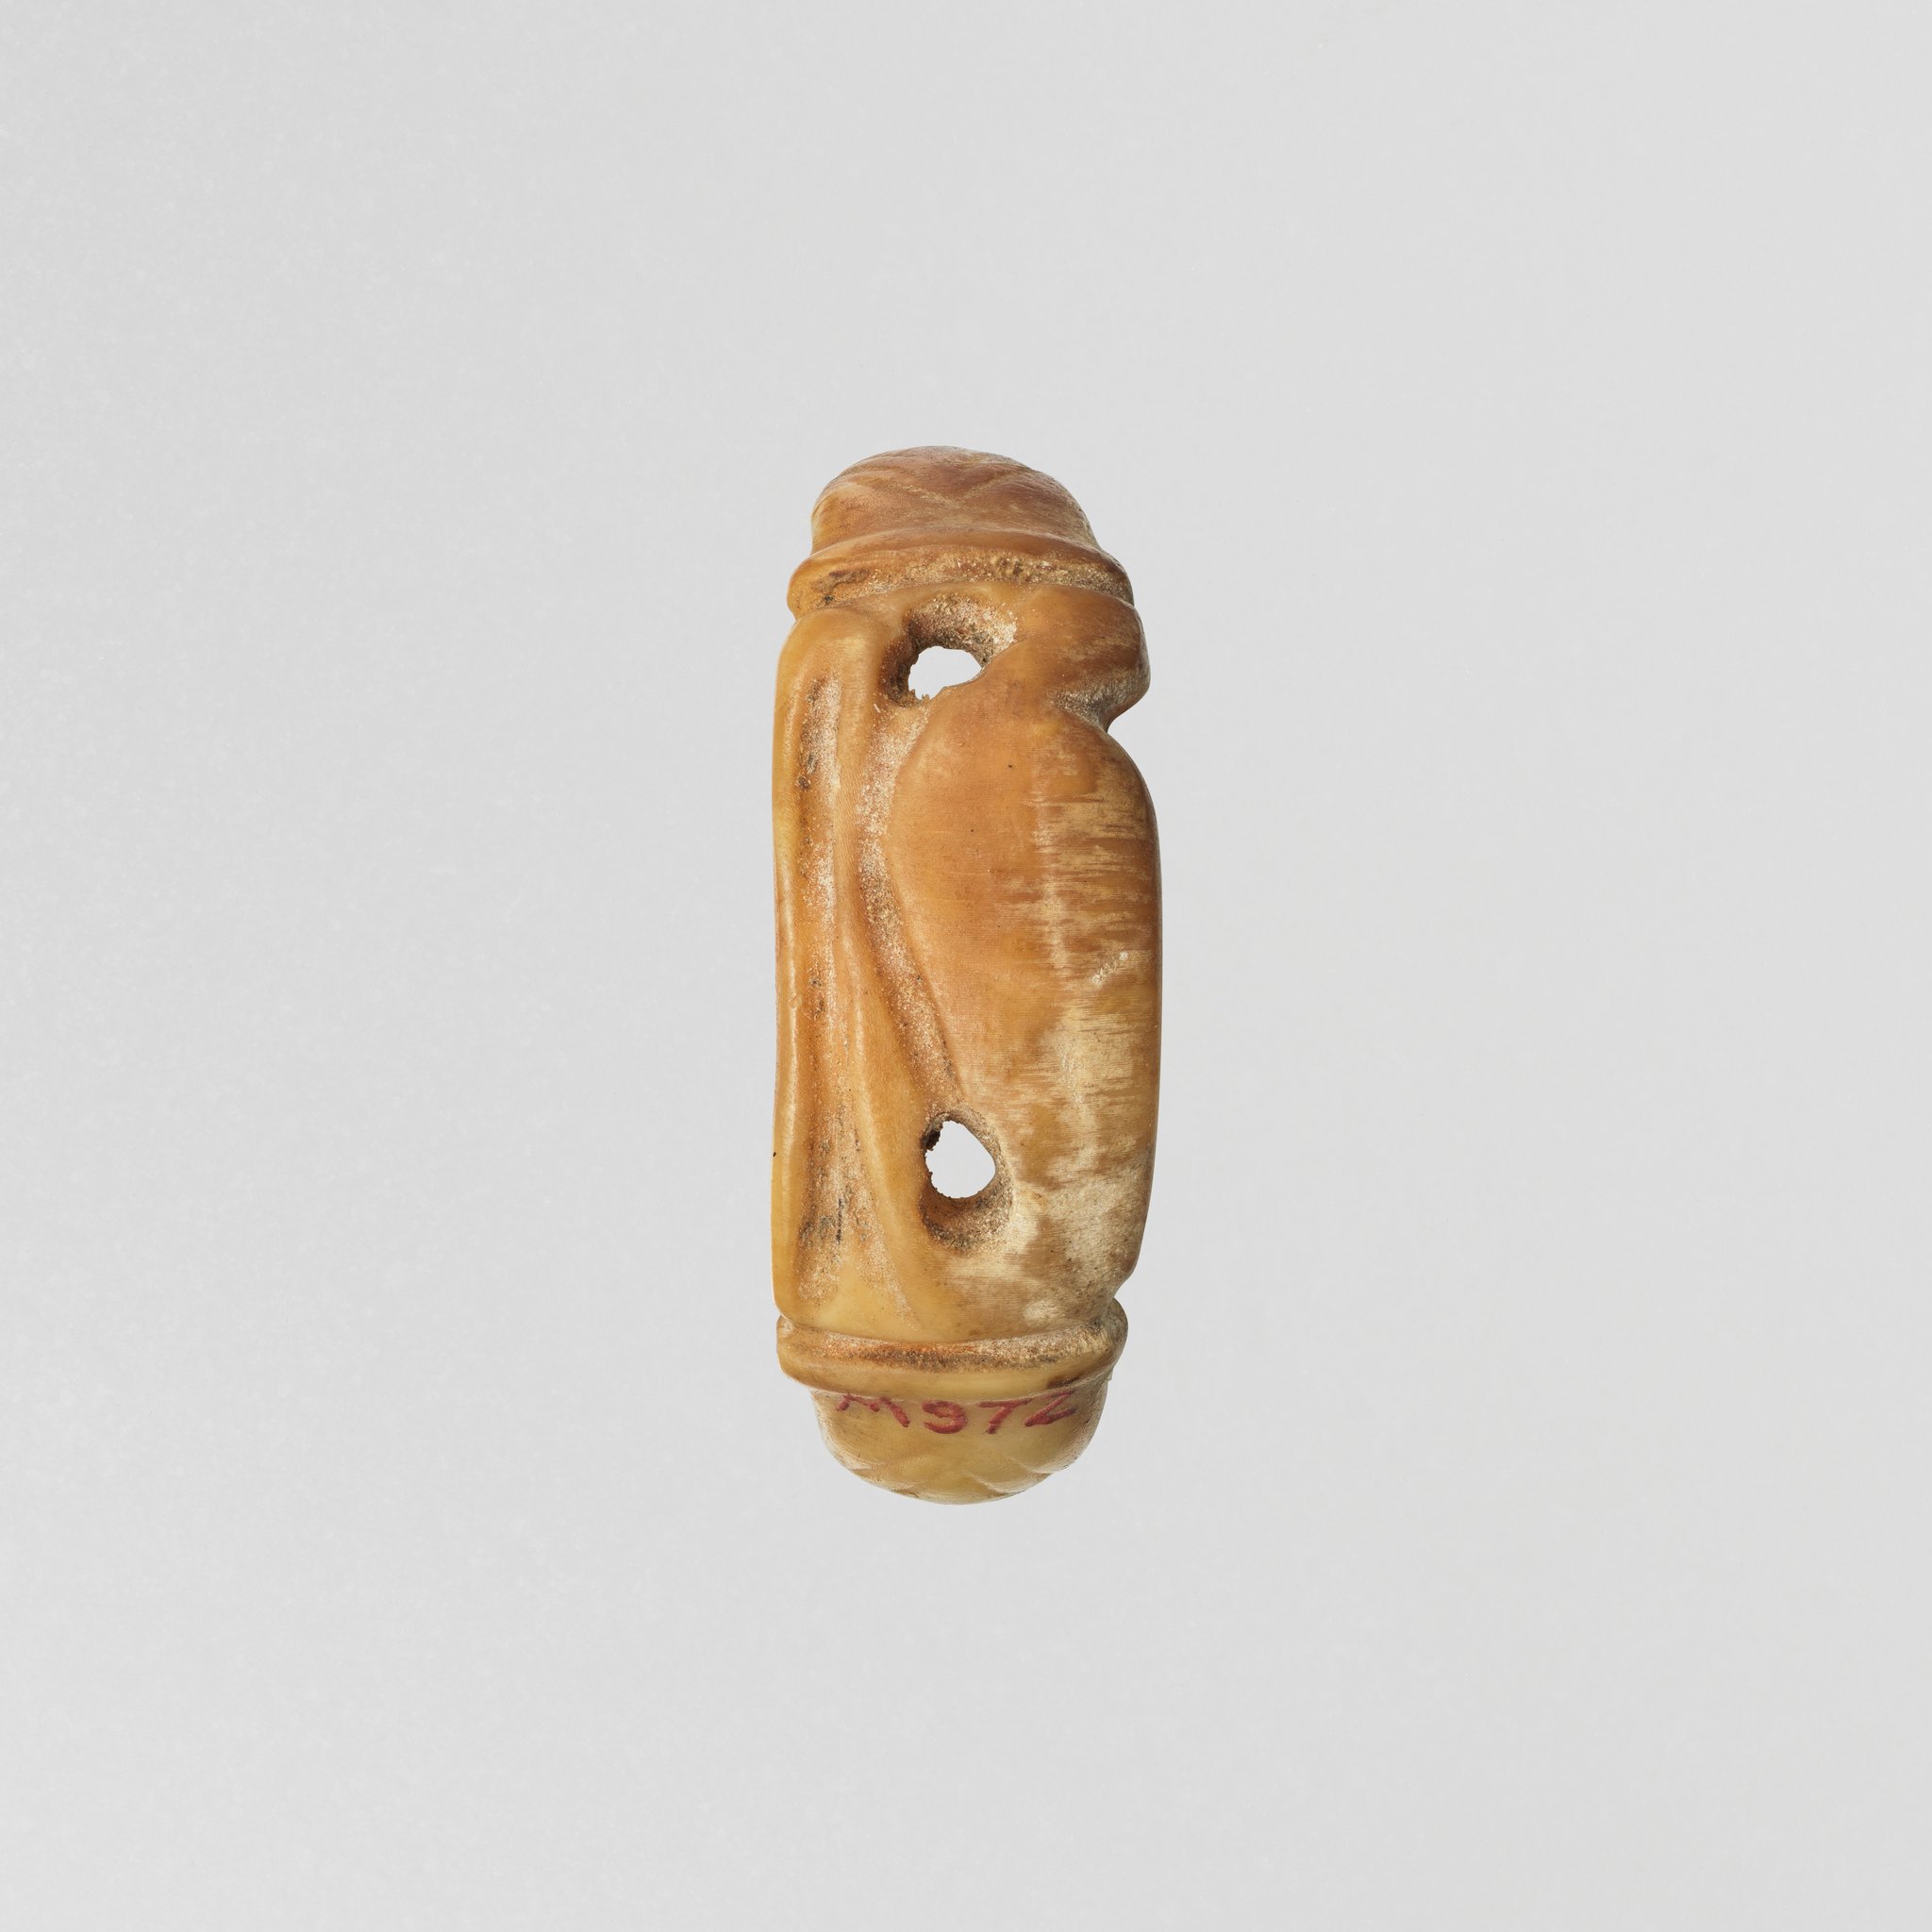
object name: ring with a bezel in the form of a uraeus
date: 1070-712 BCE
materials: bone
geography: egypt